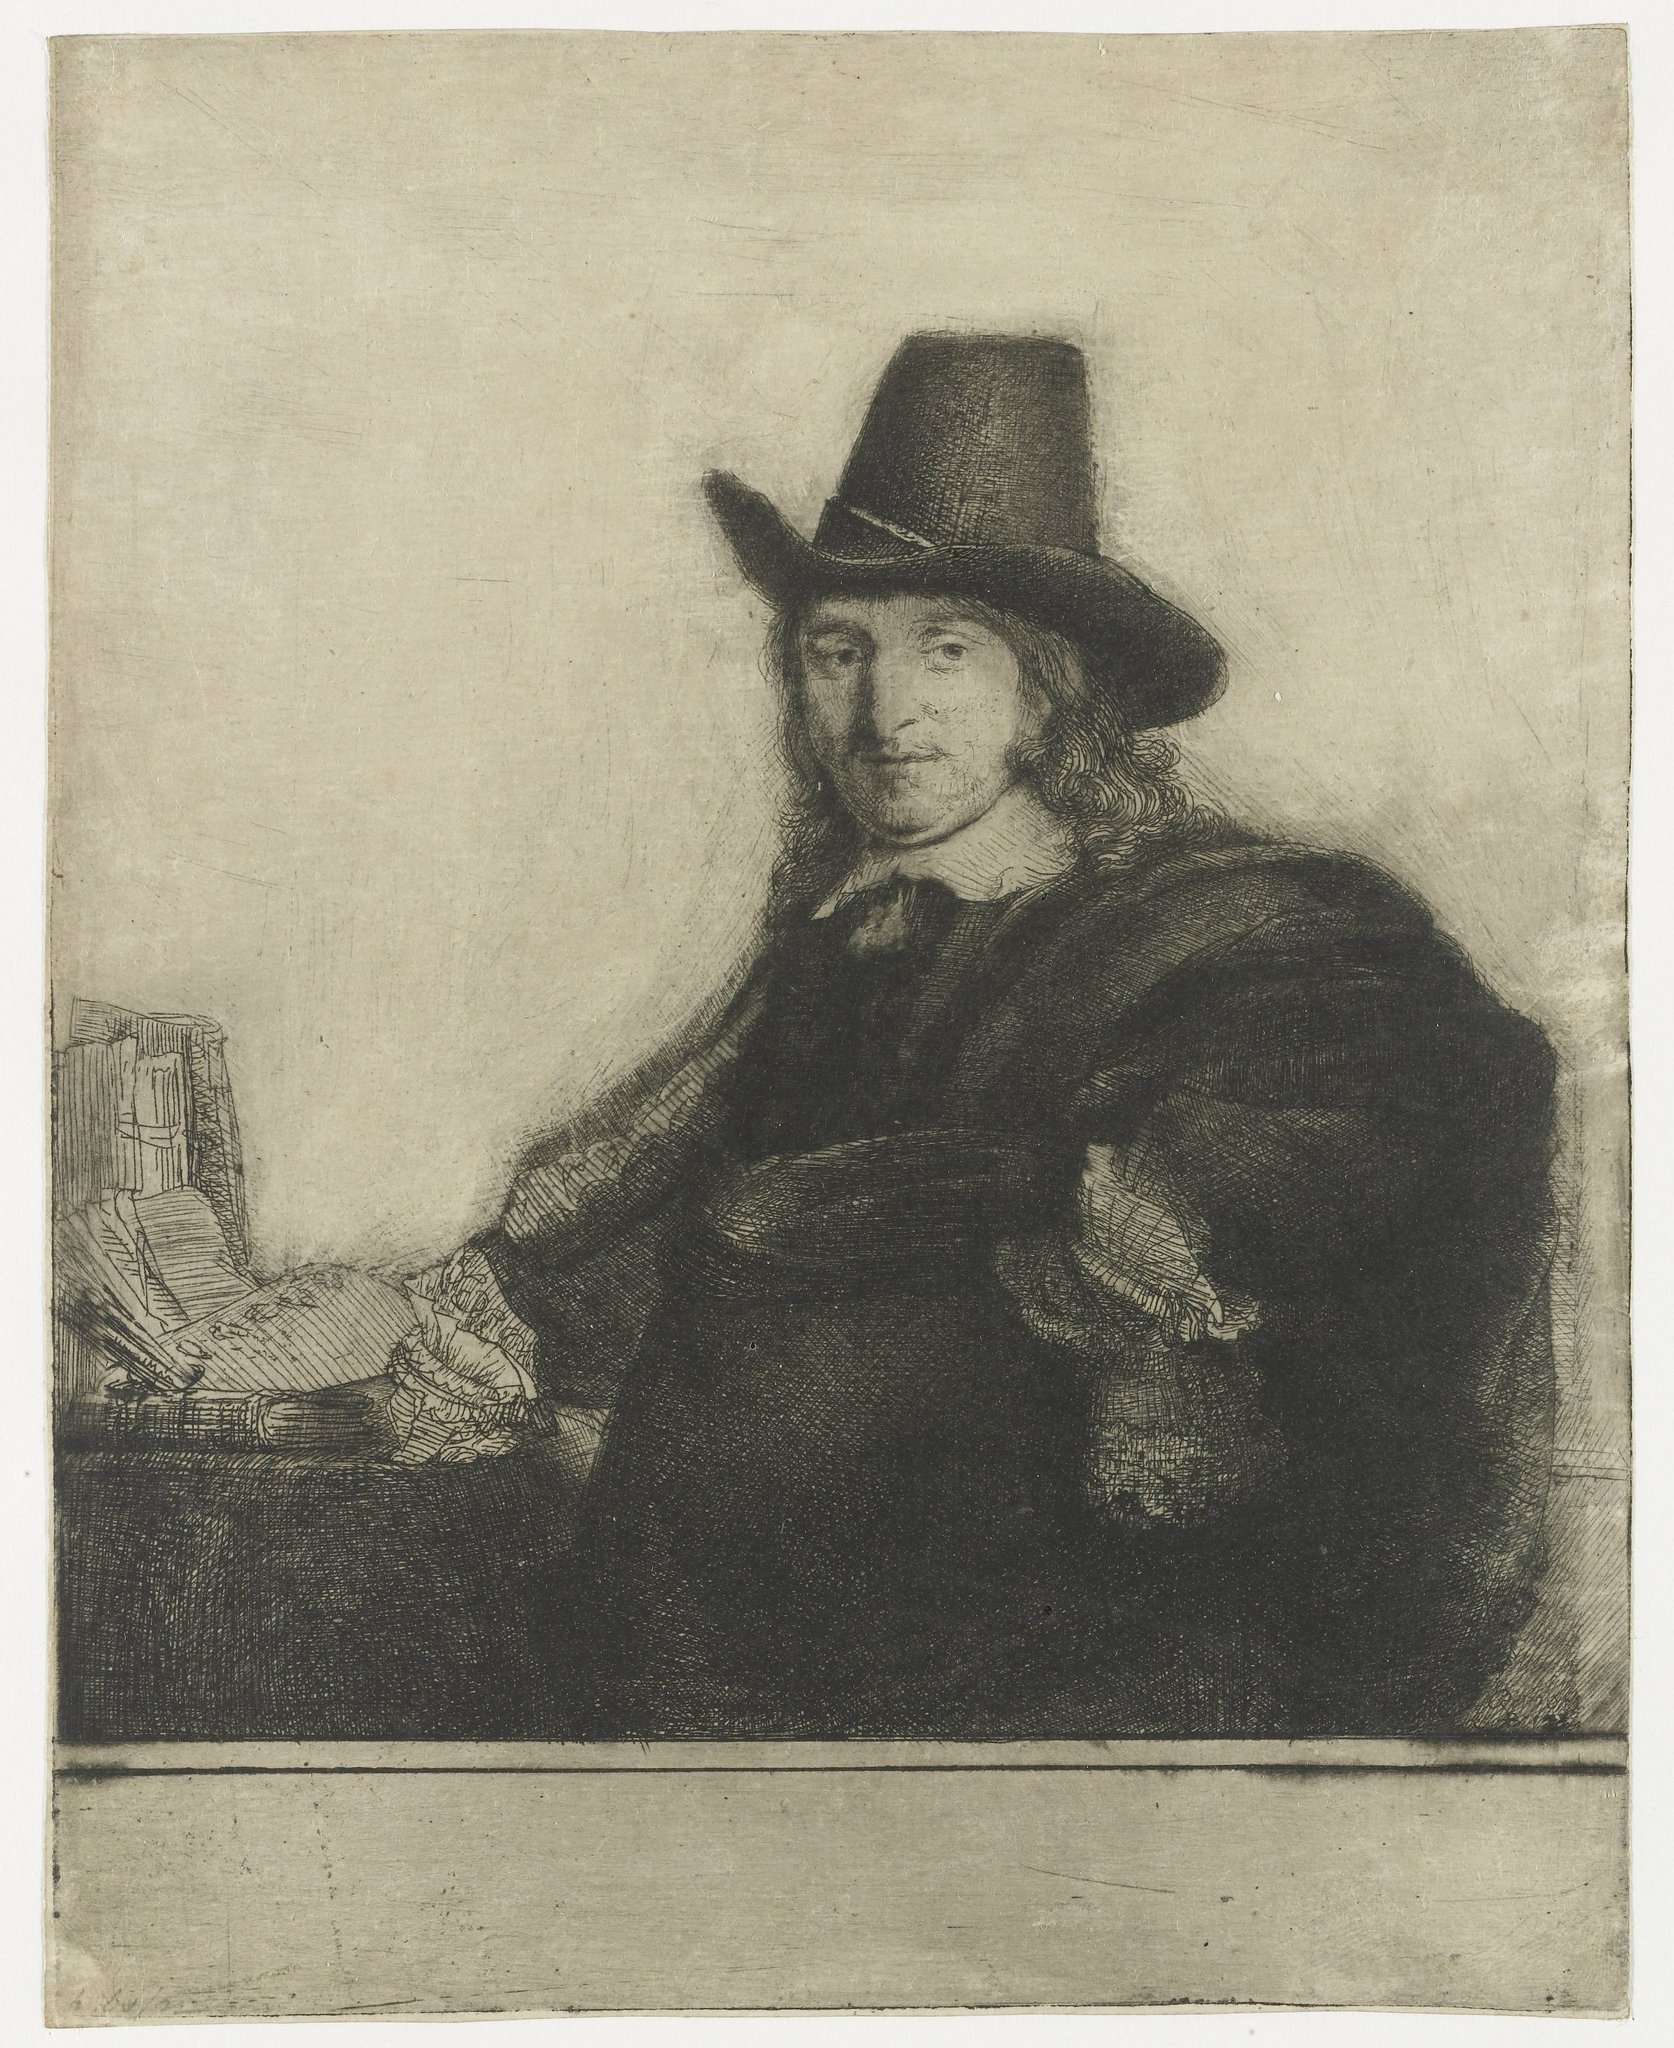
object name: print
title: Jan Asselijn, painter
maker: rembrandt van rijn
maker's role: draughtsman, painter, print maker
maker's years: 1606-1669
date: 1647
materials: paper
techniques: drypoint, etching, intaglio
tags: amsterdam, draughtsman, jan asselijn, portrait, self-portrait of painter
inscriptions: collector's mark: Lugt 2228, inscription: ‘Magnifique épreuve (...) Collection Wilson’, collector's mark: ‘W’ Lugt 2592, signature and date: ‘Rembr / f 16’, inscription: ‘Haring 81’